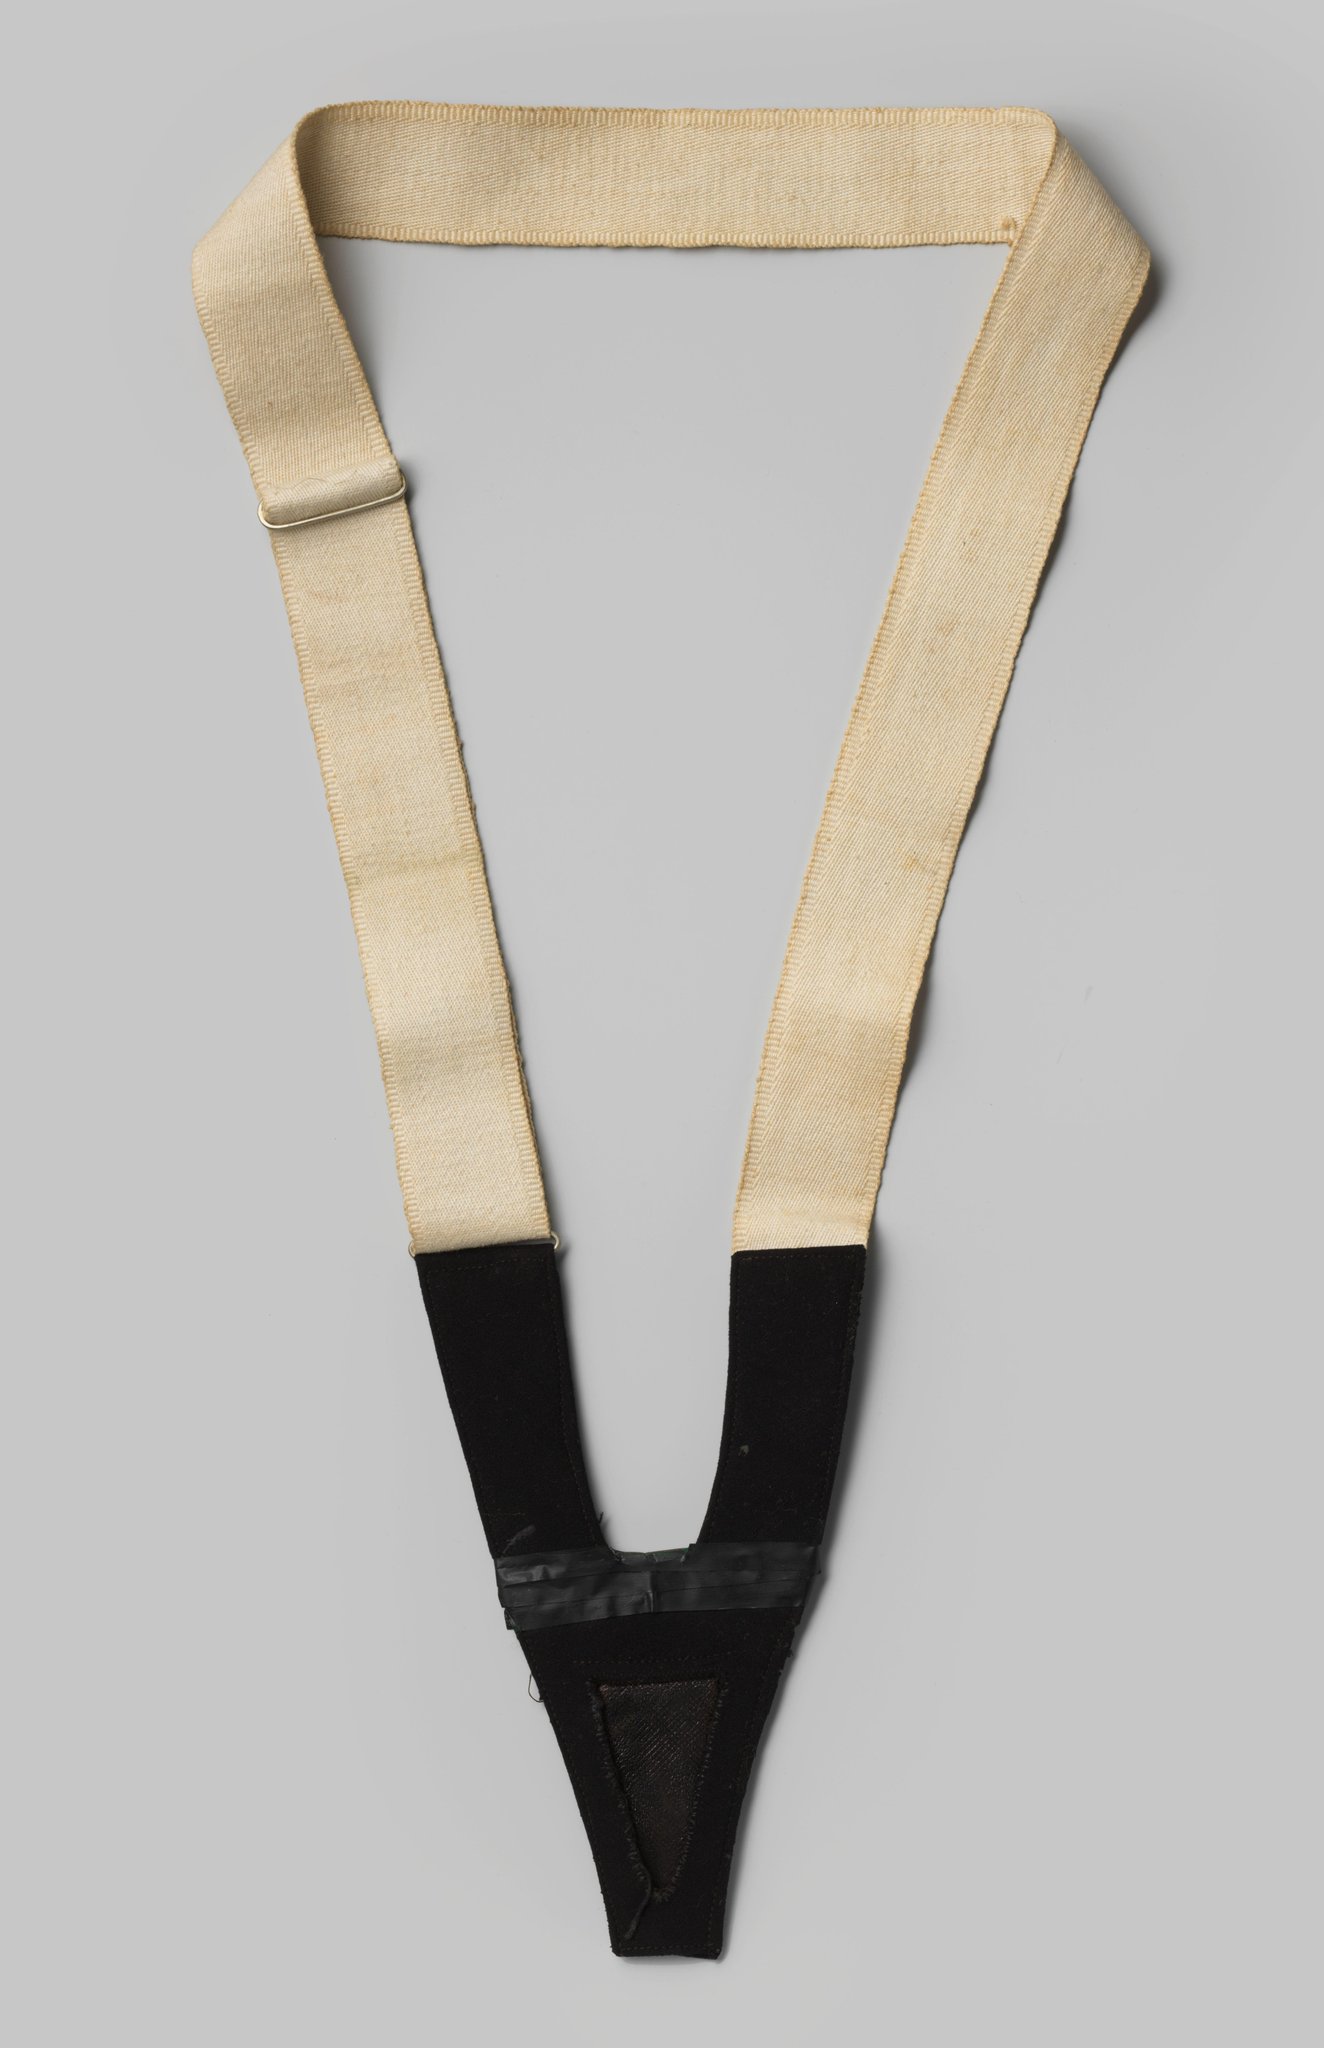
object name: ambtskleding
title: Degendrager van ambtskostuum van burgemeester Hoytema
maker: Anonymous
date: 1800-1930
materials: textile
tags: c.p. hoytema van konijnenburg, scherpenzeel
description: Kostuum is gedragen door hem als burgemeester van Scherpenzeel en daarvoor door zijn vader als burgemeester van Bergambacht, Enkhuizen en Naarden